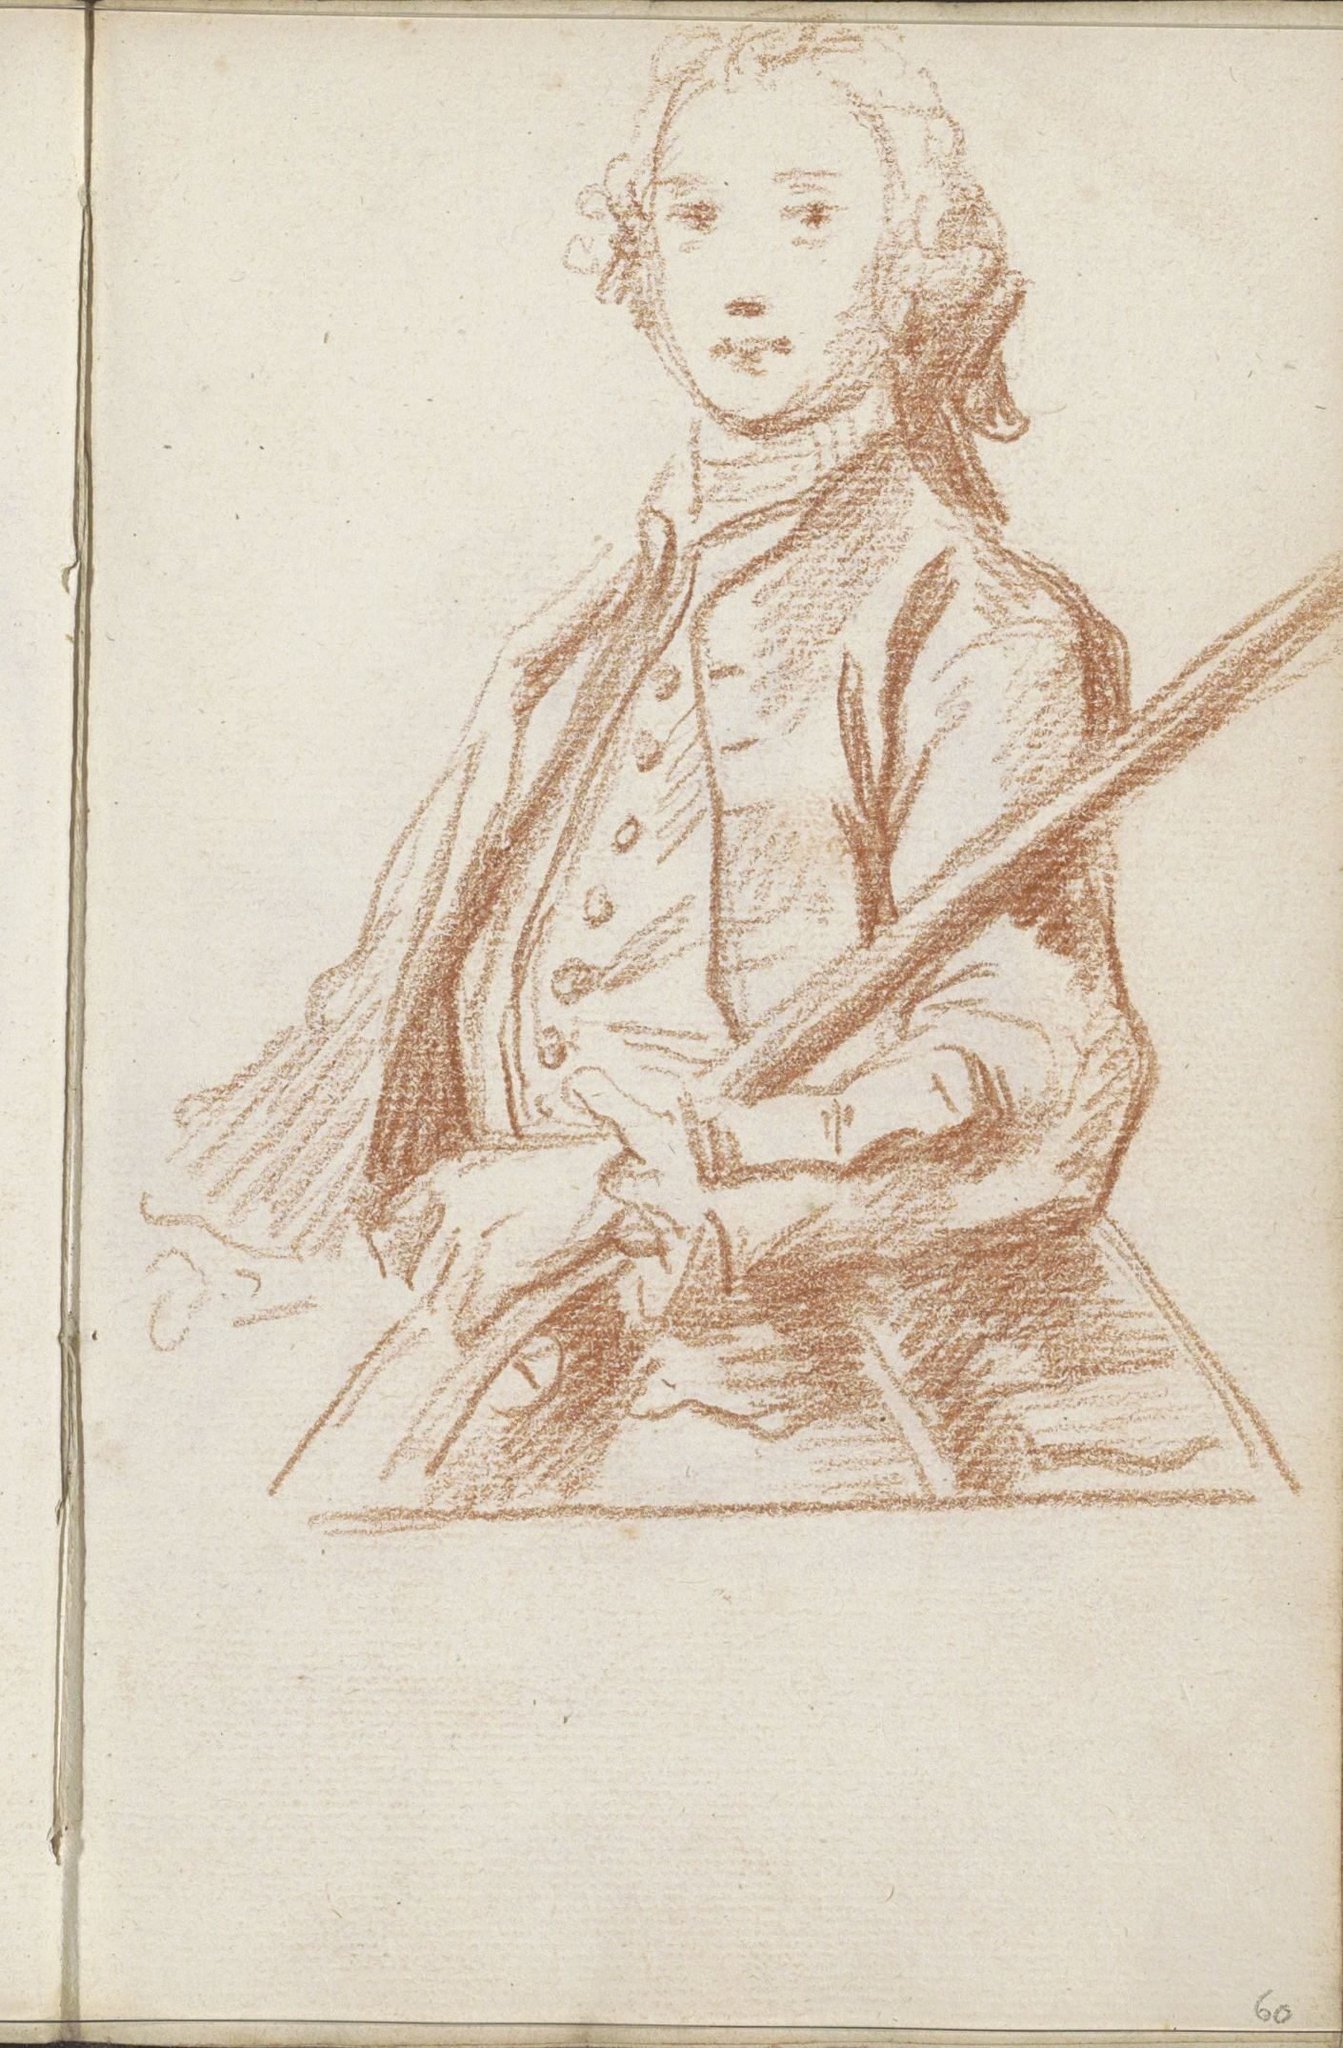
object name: sketchbook leaf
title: Staande man met geweer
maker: petrus johannes van reysschoot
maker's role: draughtsman, print maker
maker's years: 1702-1772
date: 1710-1772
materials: chalk, paper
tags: standing figure, firearms: rifle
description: Blad 60 recto uit een schetsboek met 105 bladen.